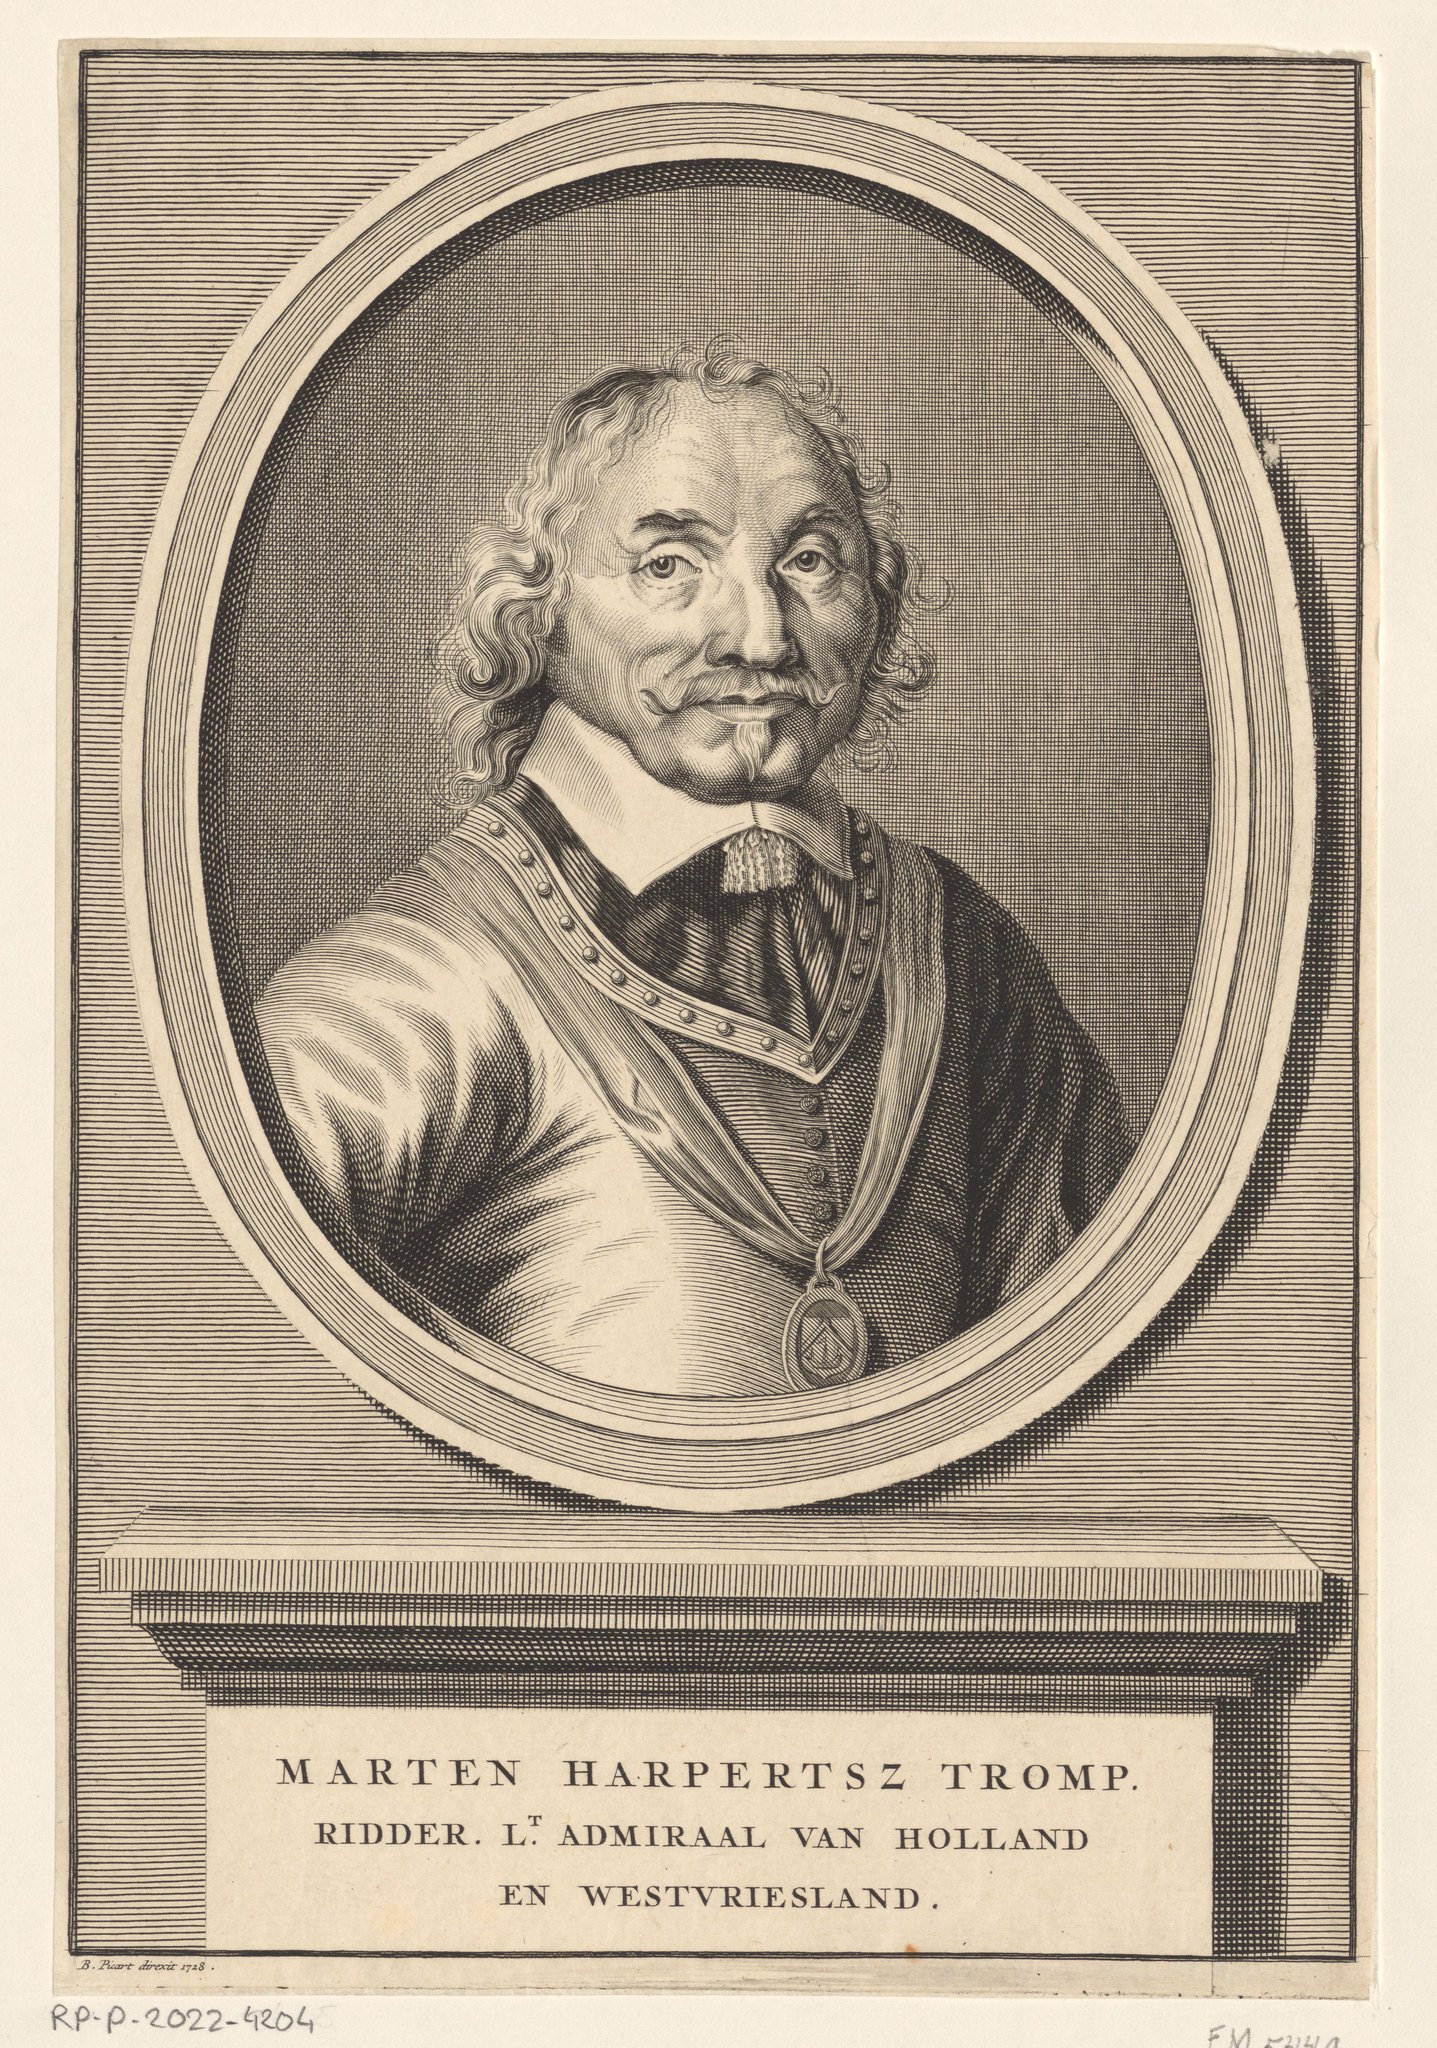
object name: print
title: Portret van Maarten Harpertszoon Tromp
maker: bernard picart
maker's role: draughtsman, print maker, publisher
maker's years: 1673-1733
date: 1728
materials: paper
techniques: engraving, etching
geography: amsterdam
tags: brielle, maarten harpertszoon tromp, historical persons, medals and other marks of military honour, commander-in-chief, admiral